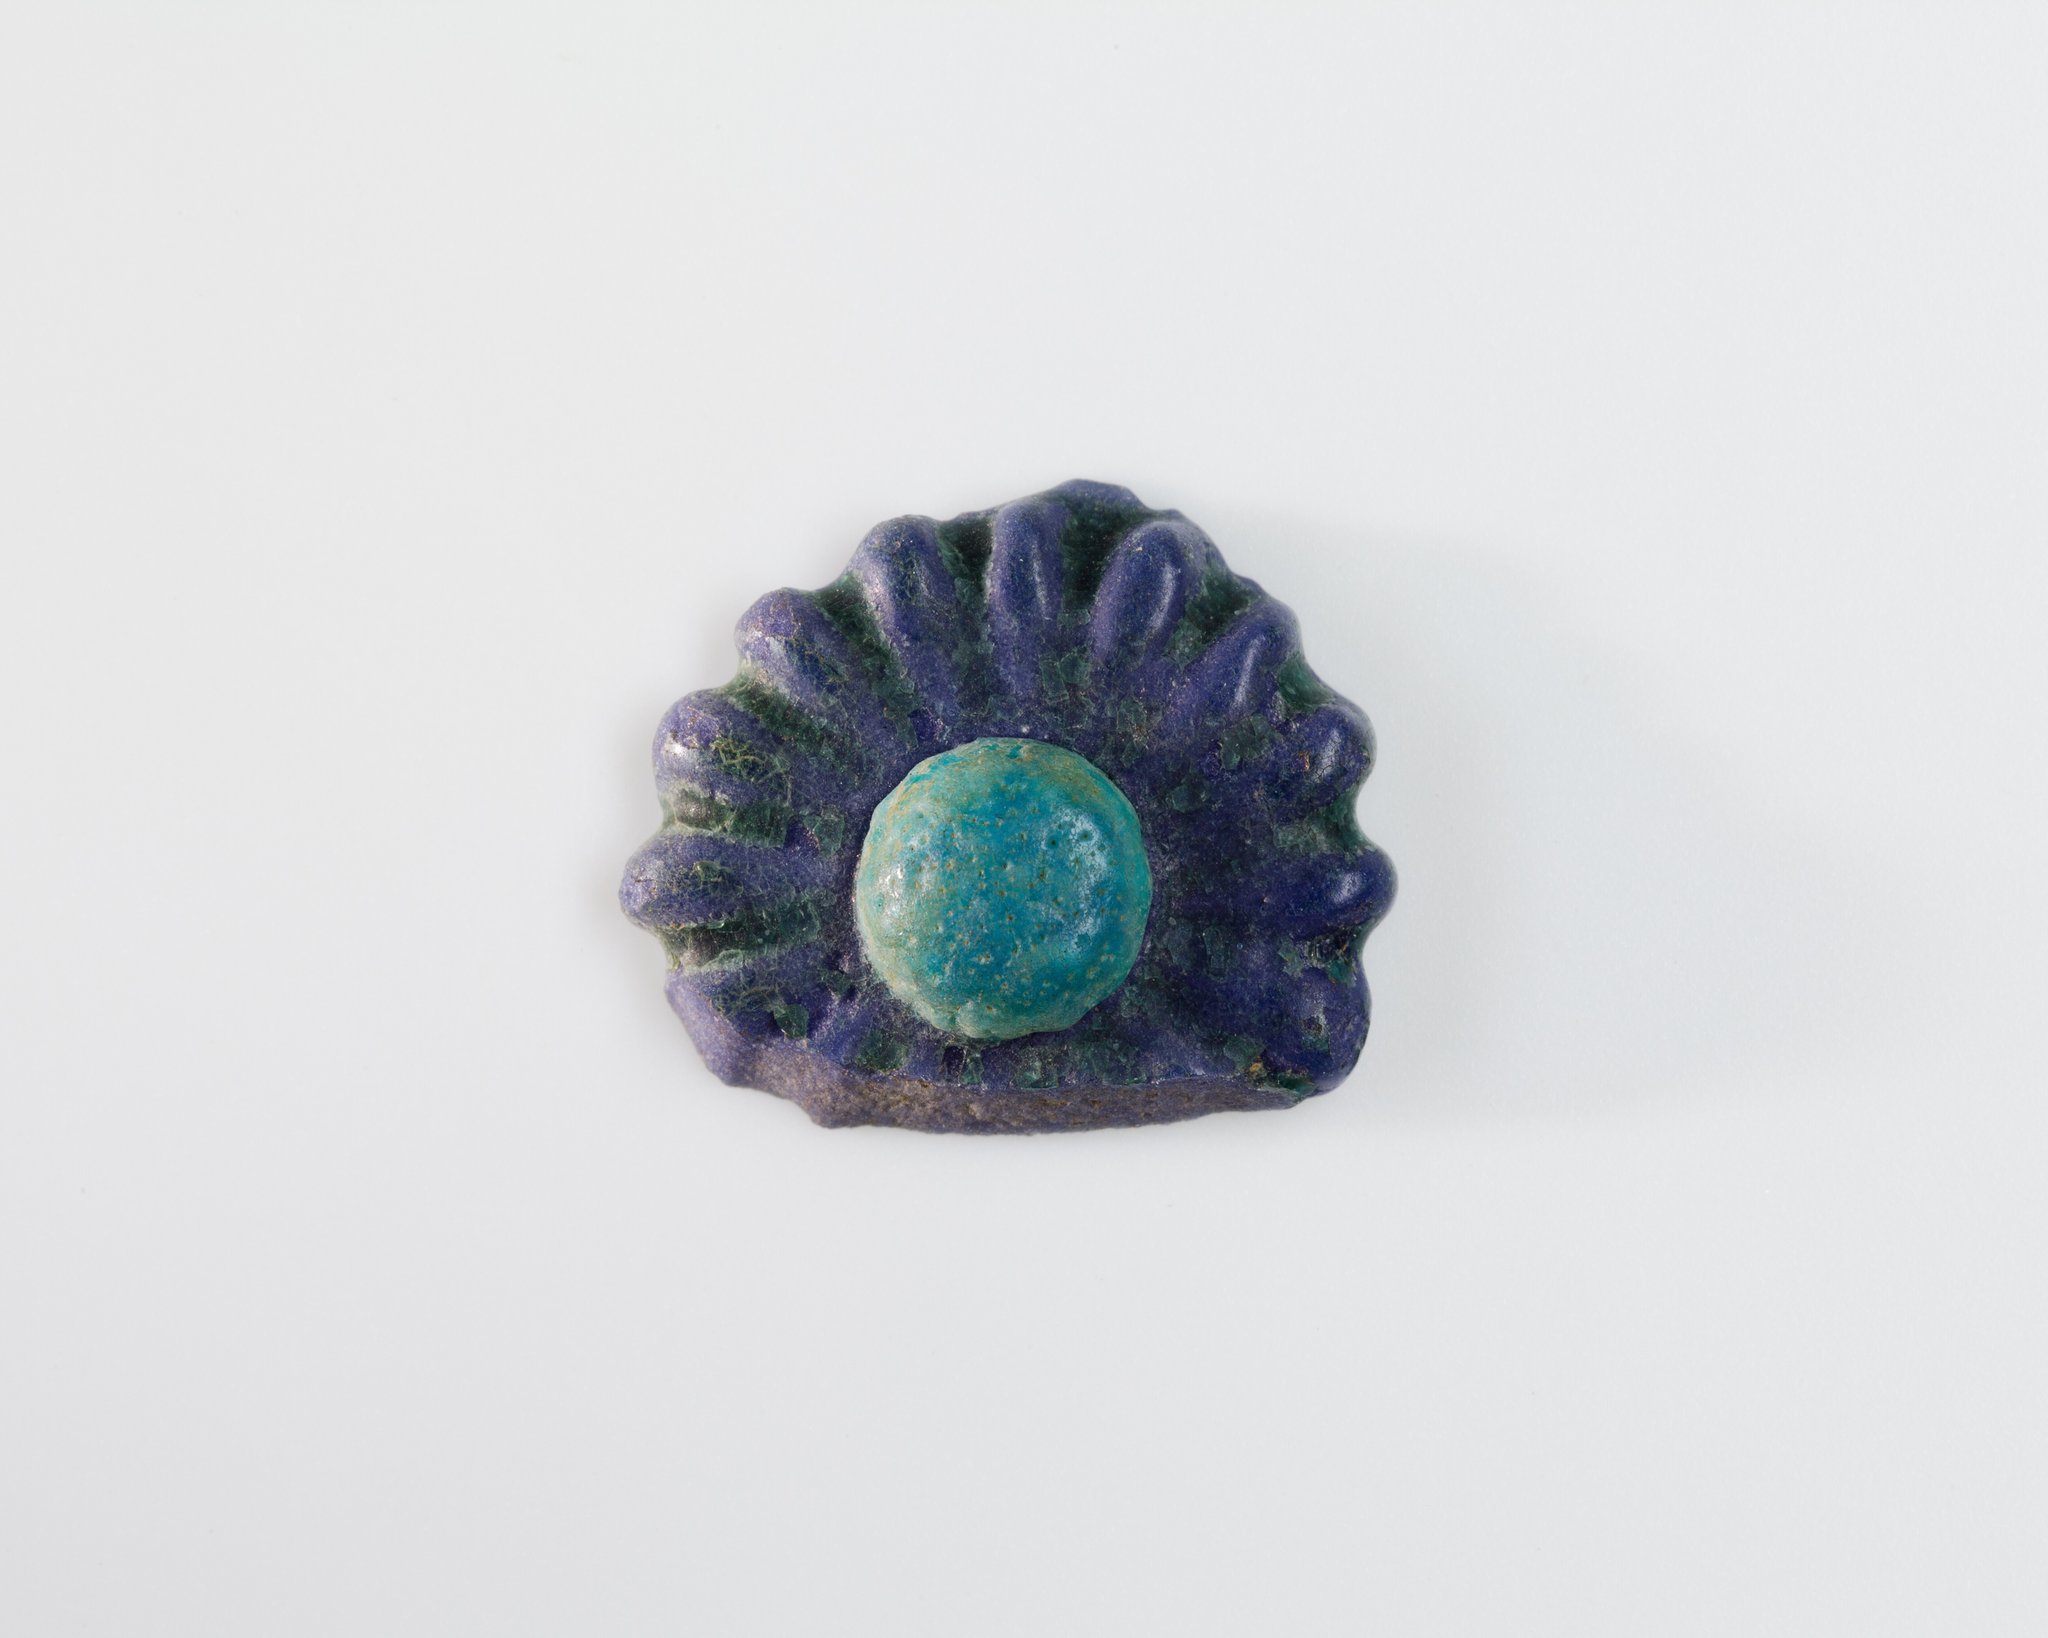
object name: pendant, daisy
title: Daisy Pendant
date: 1390-1352 BCE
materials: faience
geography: egypt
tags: daisies